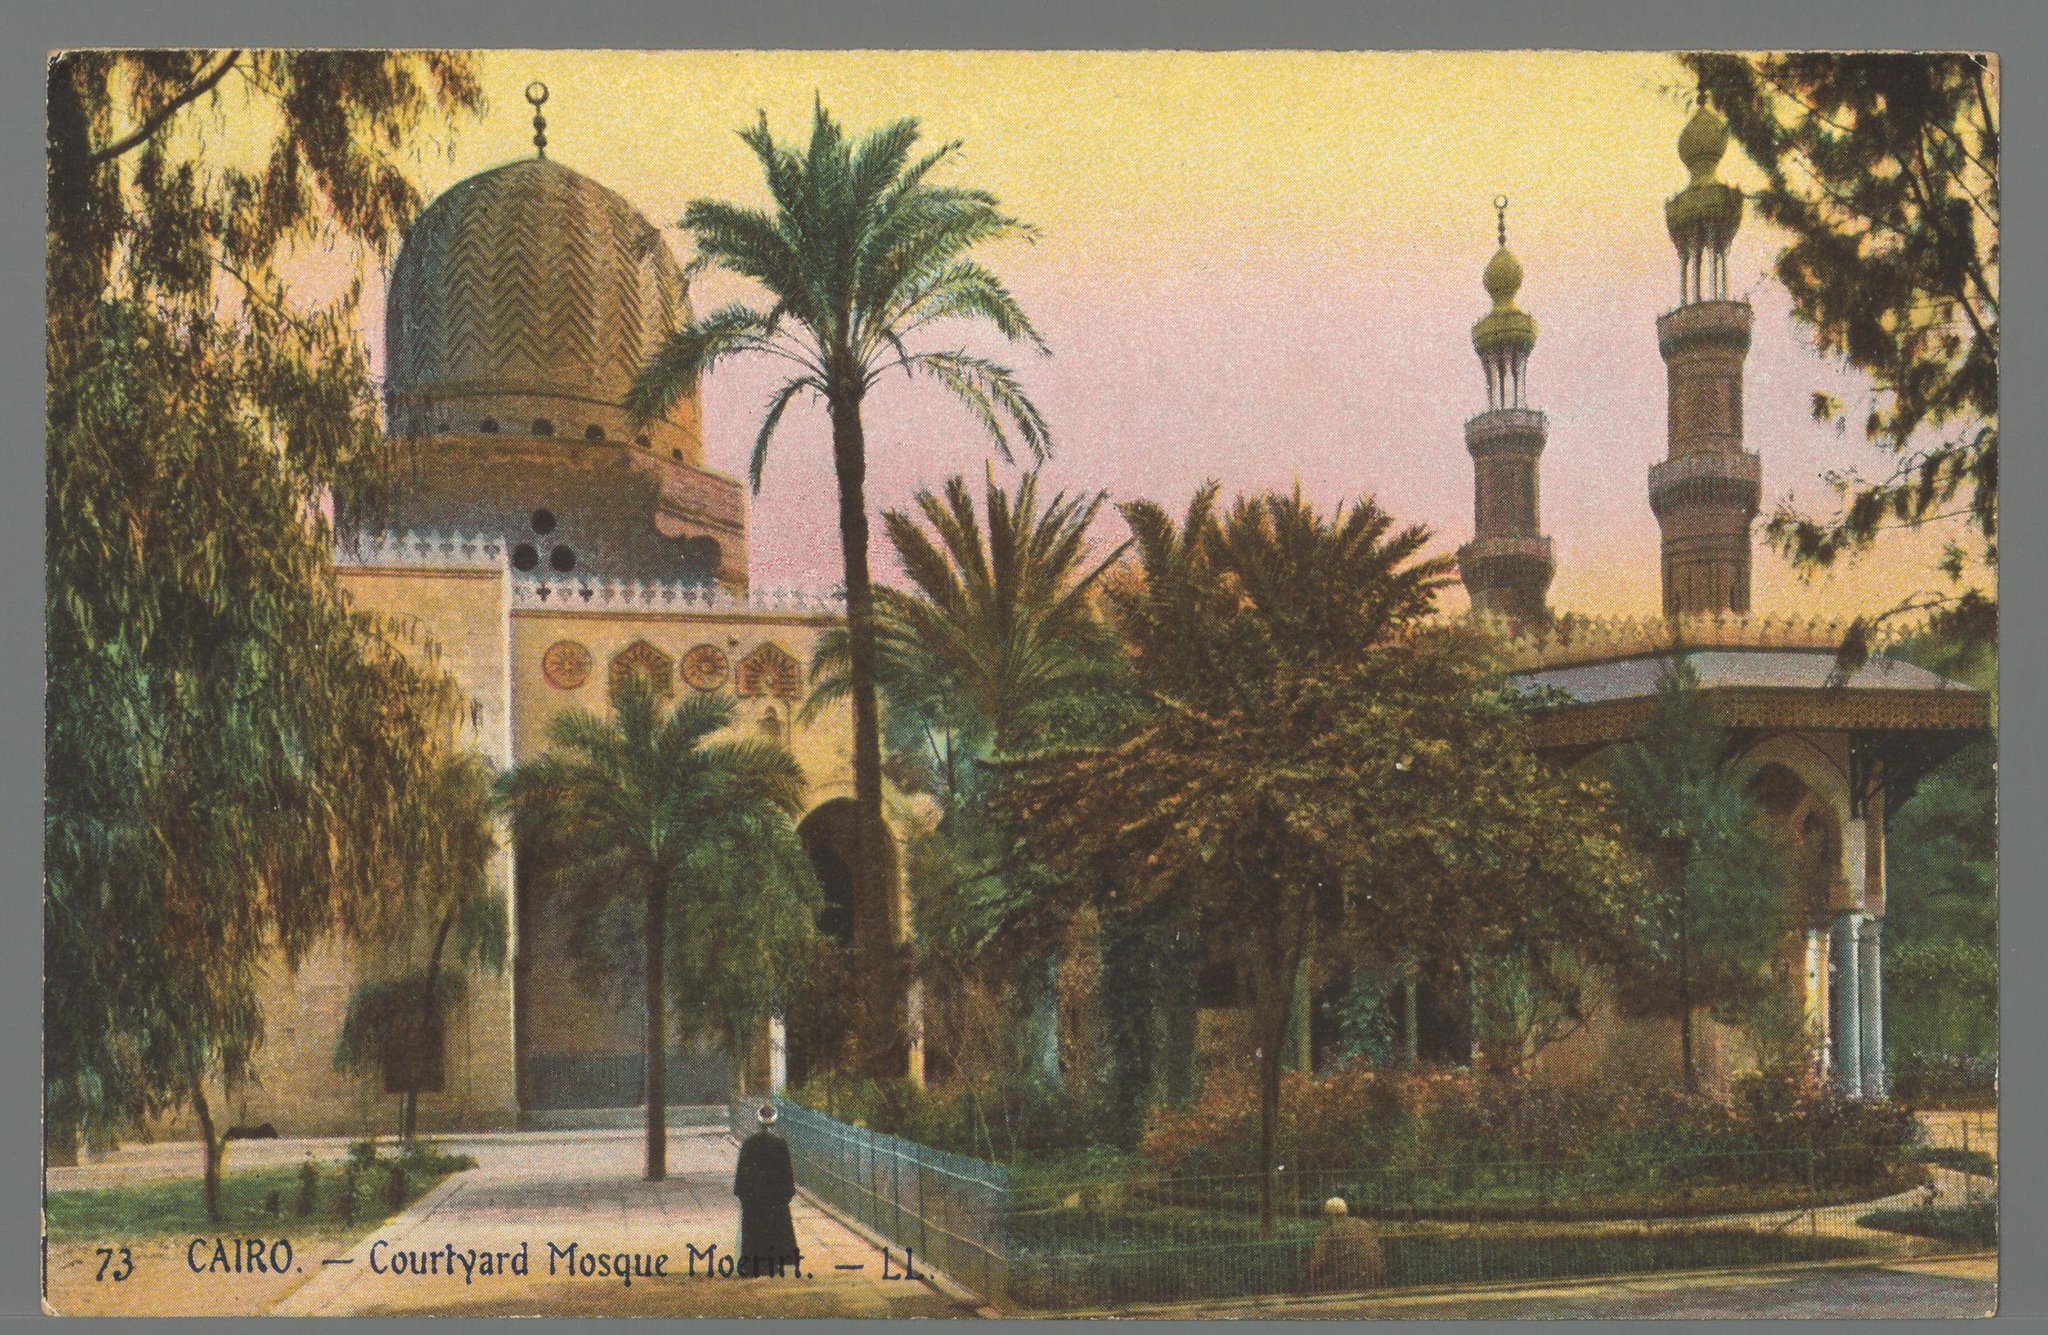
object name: photomechanical print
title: Cairo - Courtyard Mosque Moerirt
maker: Anonymous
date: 1907-1930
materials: cardboard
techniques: lithograph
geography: cairo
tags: garden, temple, shrine ~ islam, mohammedanism